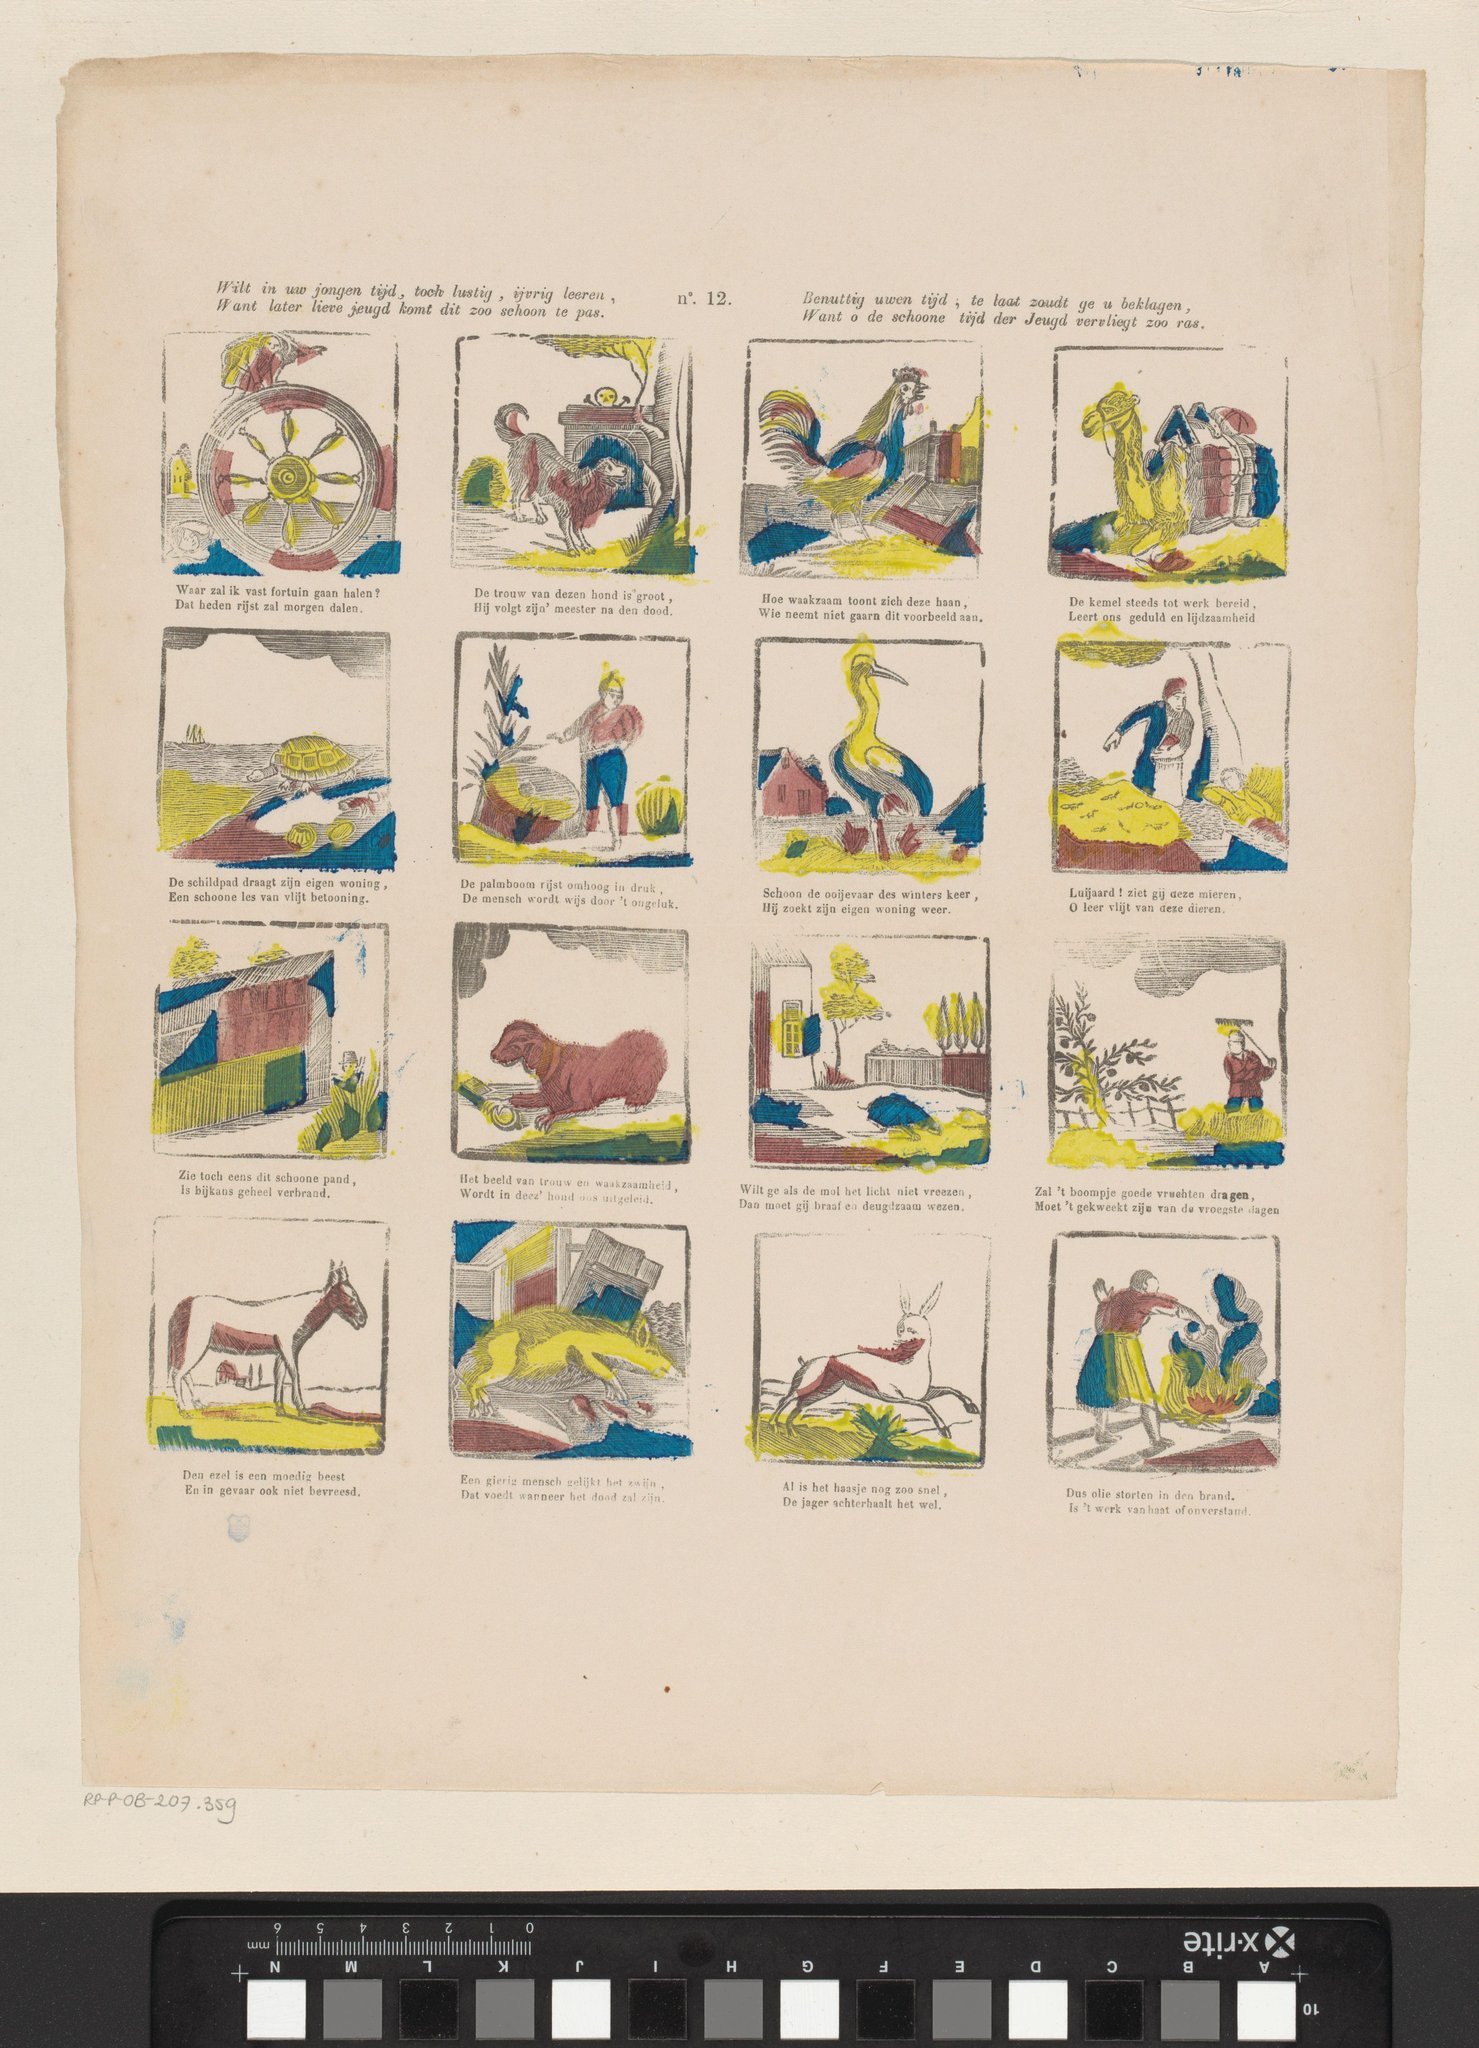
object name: print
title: Wilt in uw jongen tijd, toch lustig, ijvrig leeren, / Want later lieve jeugd komt dit zoo schoon te pas. / Benuttig uwen tijd, te laat zoudt ge u beklagen, / Want o de schoone tijd der jeugd vervliegt zoo ras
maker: Anonymous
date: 1848-1881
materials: paper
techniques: colour, letterpress printing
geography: den bosch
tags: animals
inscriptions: collector's mark: Lugt 2760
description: Blad met 16 voorstellingen van voorwerpen, dieren en figuren. Onder elke voorstelling een tweeregelig vers. Genummerd midden boven: no. 12.